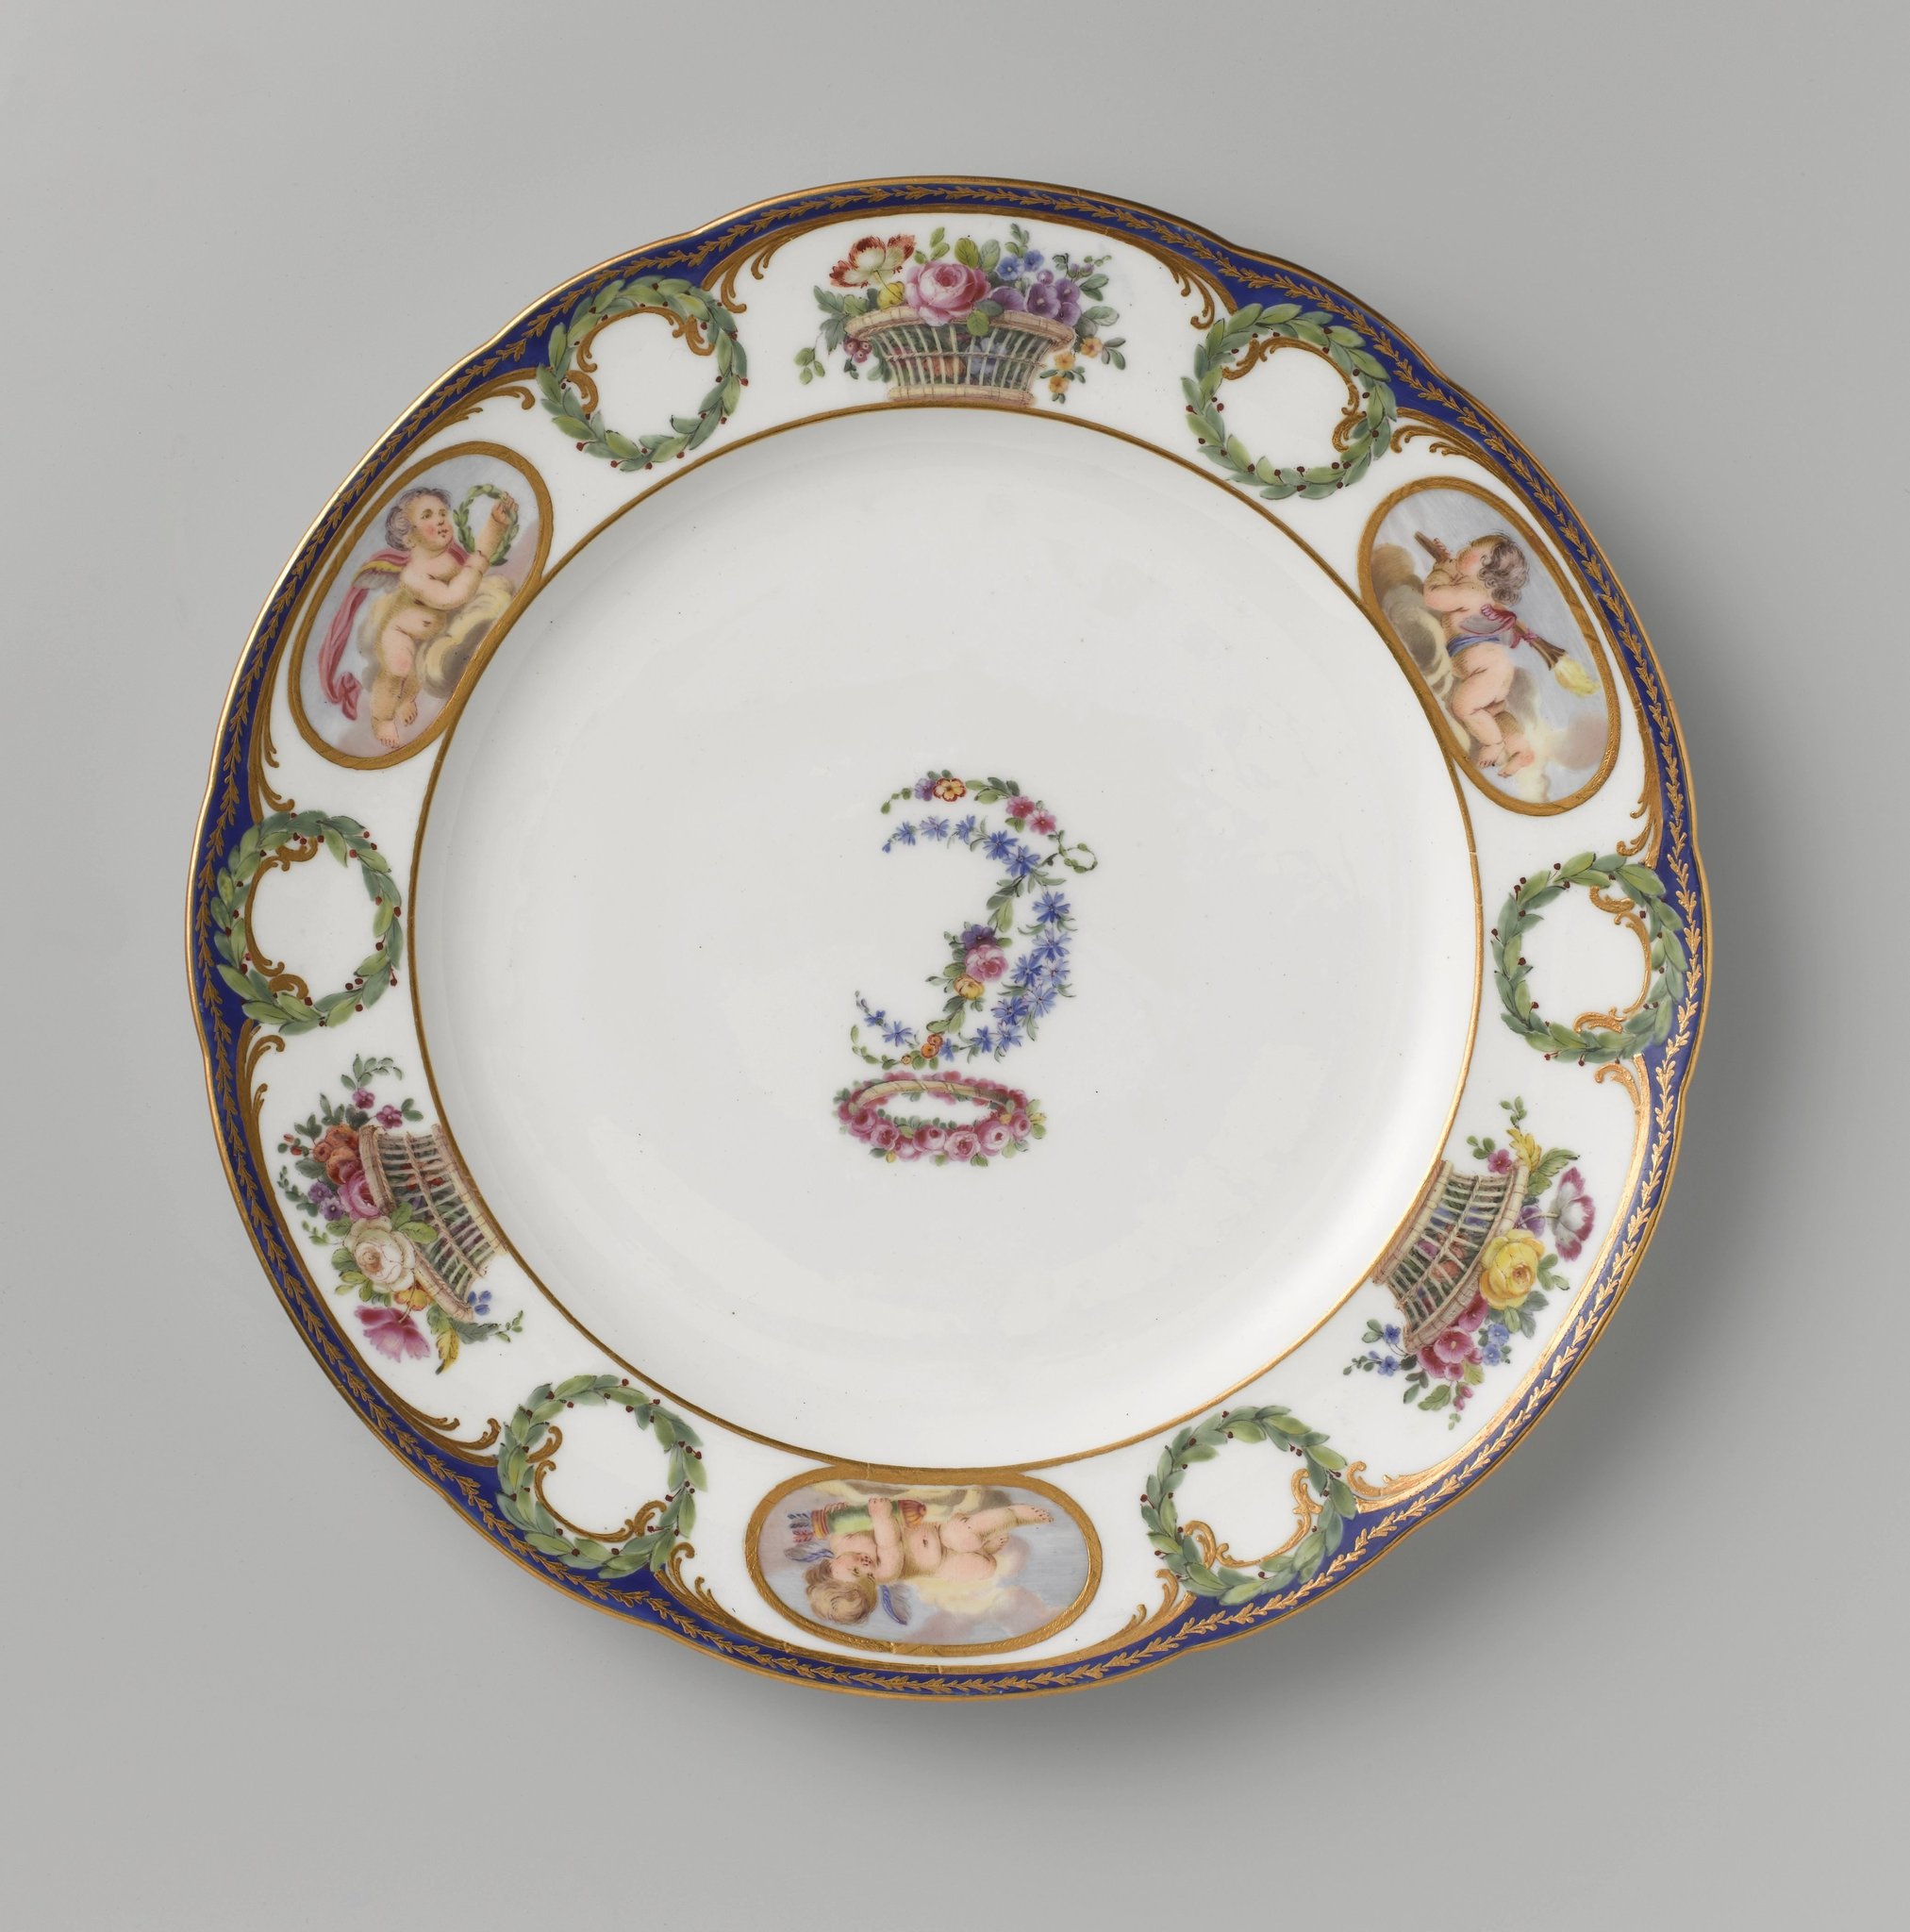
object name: plate dish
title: Plate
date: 1773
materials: porcelain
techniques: gilding, painted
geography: sèvres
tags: cupids: 'amores', 'amoretti', 'putti'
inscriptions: mark: ‘PBSC’, painter's mark: ‘ch’, mark: ‘#’, factory mark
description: This plate was part of a service that King Louis XV of France commissioned as a gift for Maria Carolina, Queen of Naples, on the occasion of the baptism of her second daughter, Louisa, in 1774. Louis XV was godfather to the princess.